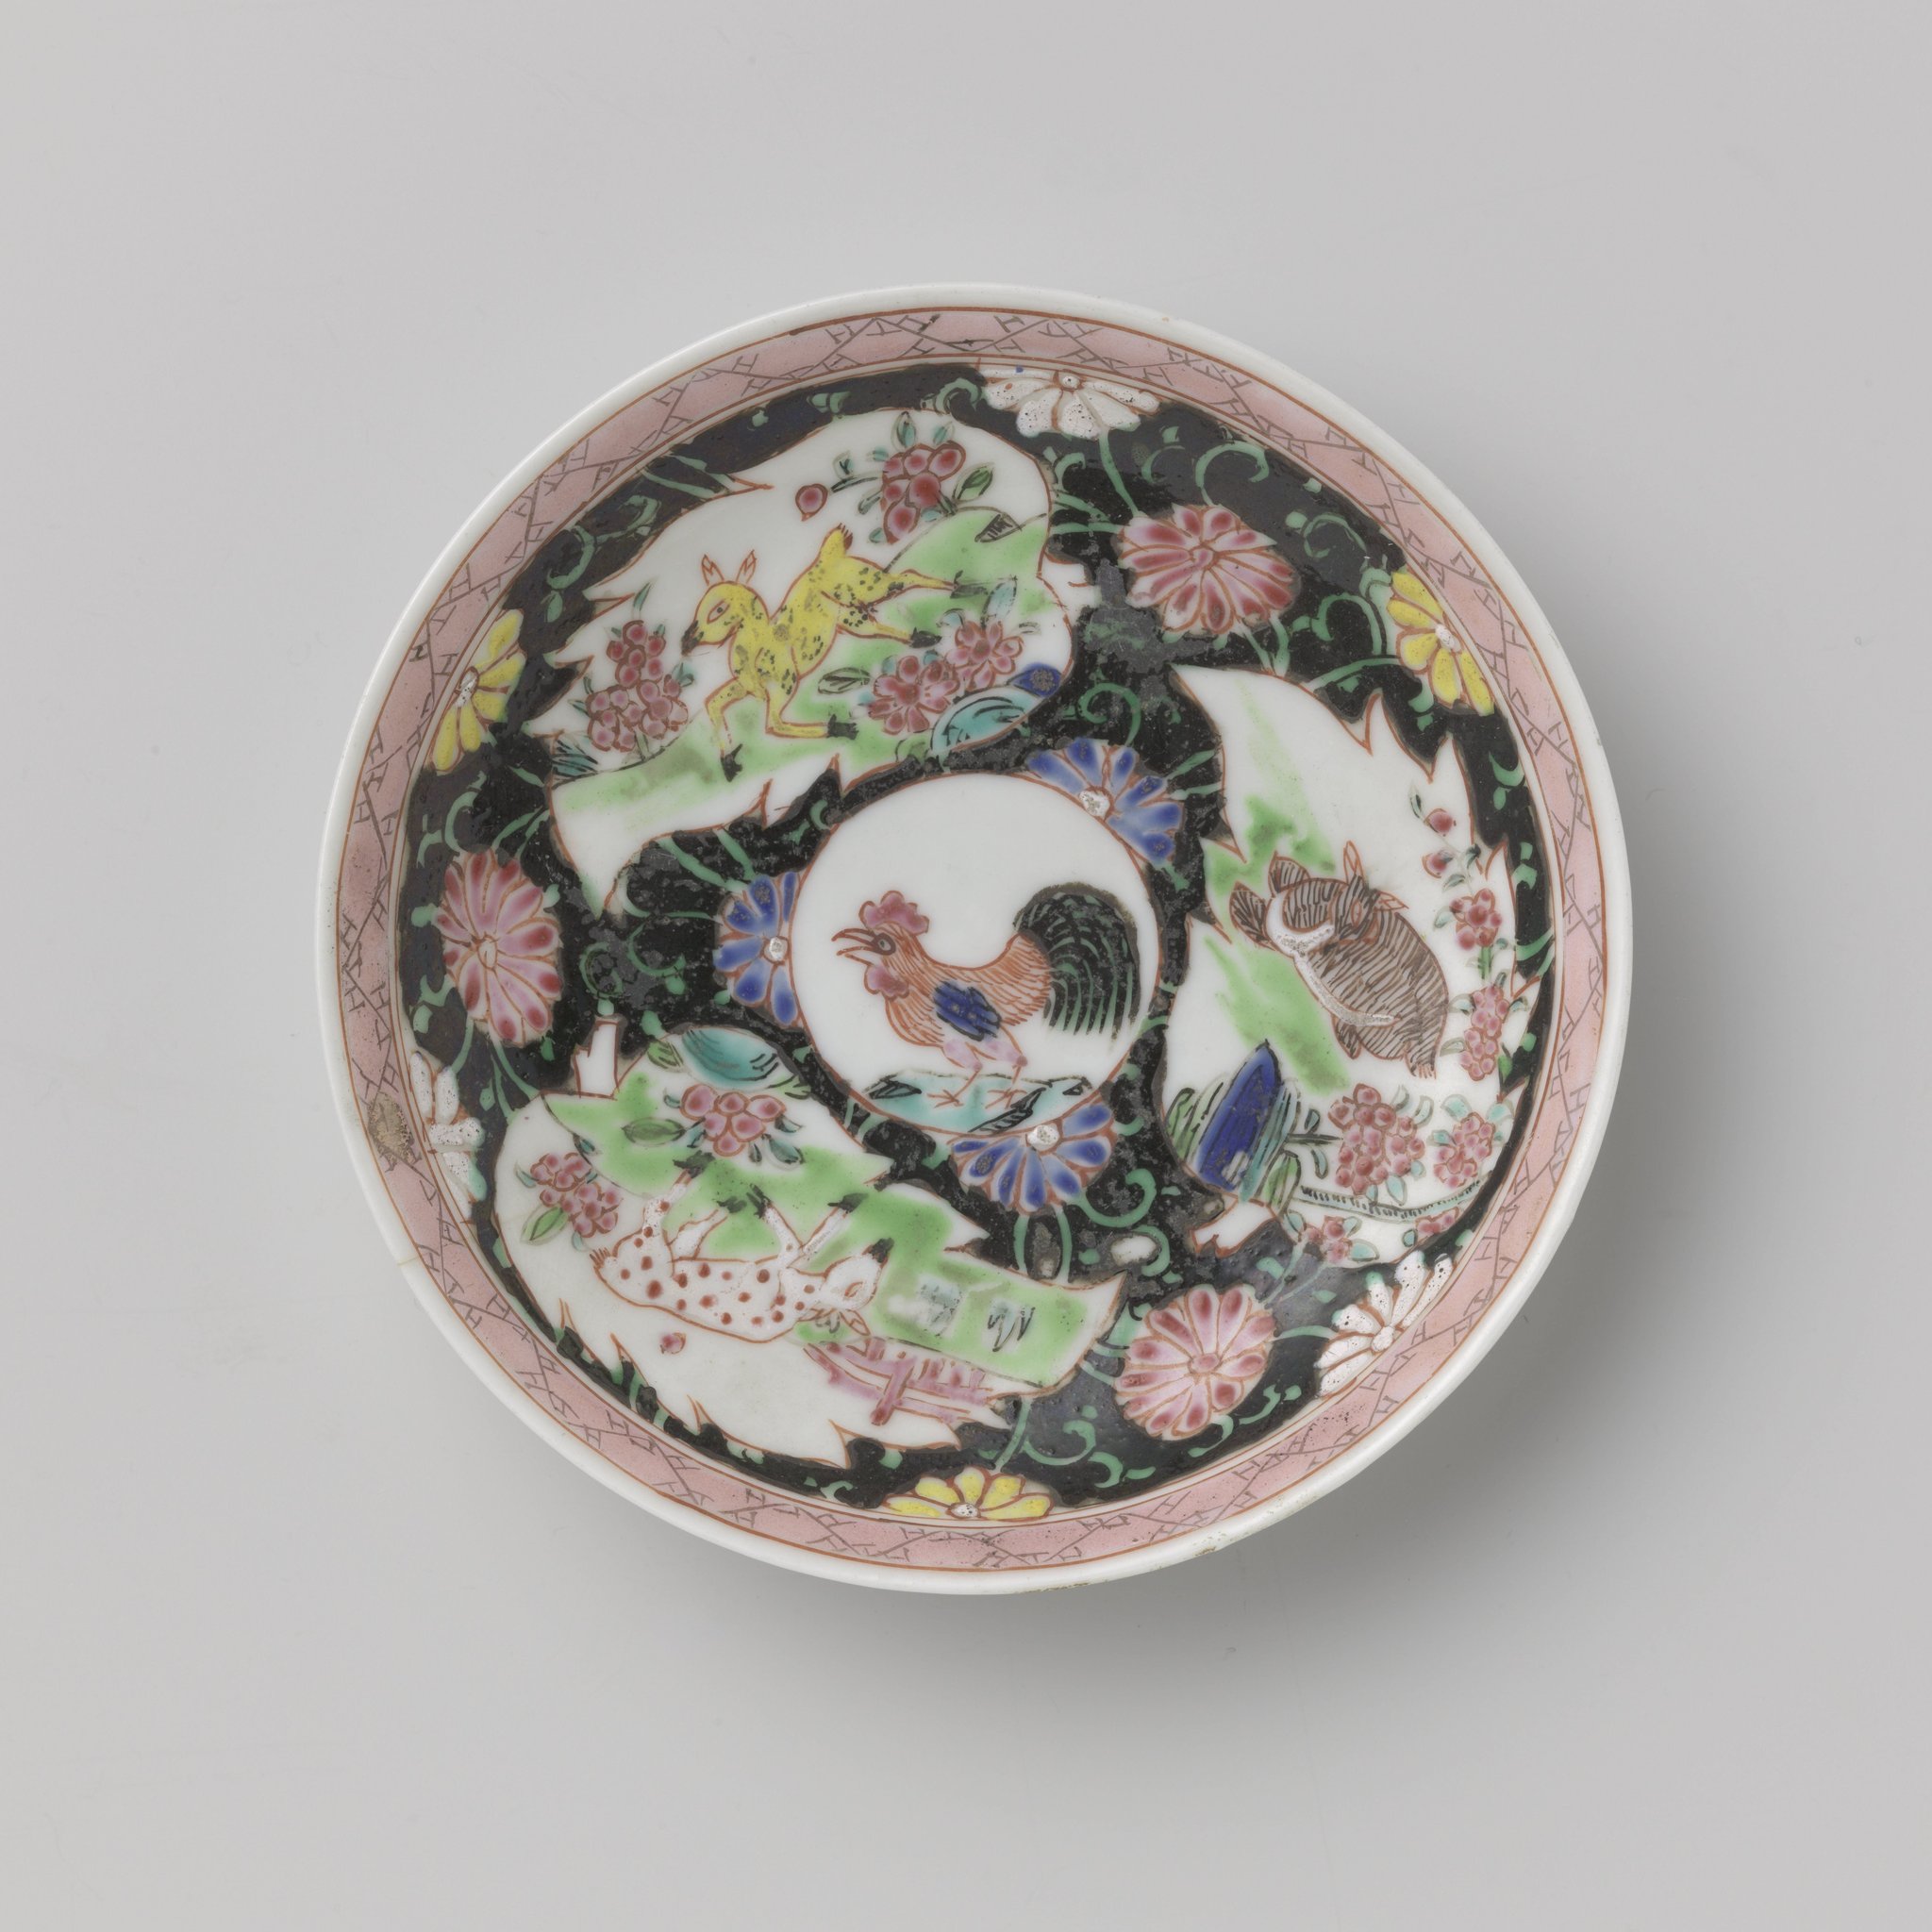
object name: platter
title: Saucer with cock and deer on a black ground with flower scrolls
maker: Anonymous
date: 1725-1749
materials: cobalt, glaze, paint, porcelain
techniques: firing, turning, vitrification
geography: china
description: Schotel van porselein, beschilderd op het glazuur in blauw, rood, roze, groen, geel en zwart. Het plat is bedekt met een zwart glazuur met in reserve bloemranken en vier cartouches: een medaillon met haan en drie bladvormige cartouches met herten in een landschap; de rand met een band roze 'crackled ice'-patroon. Een barst in de rand. Famille rose.